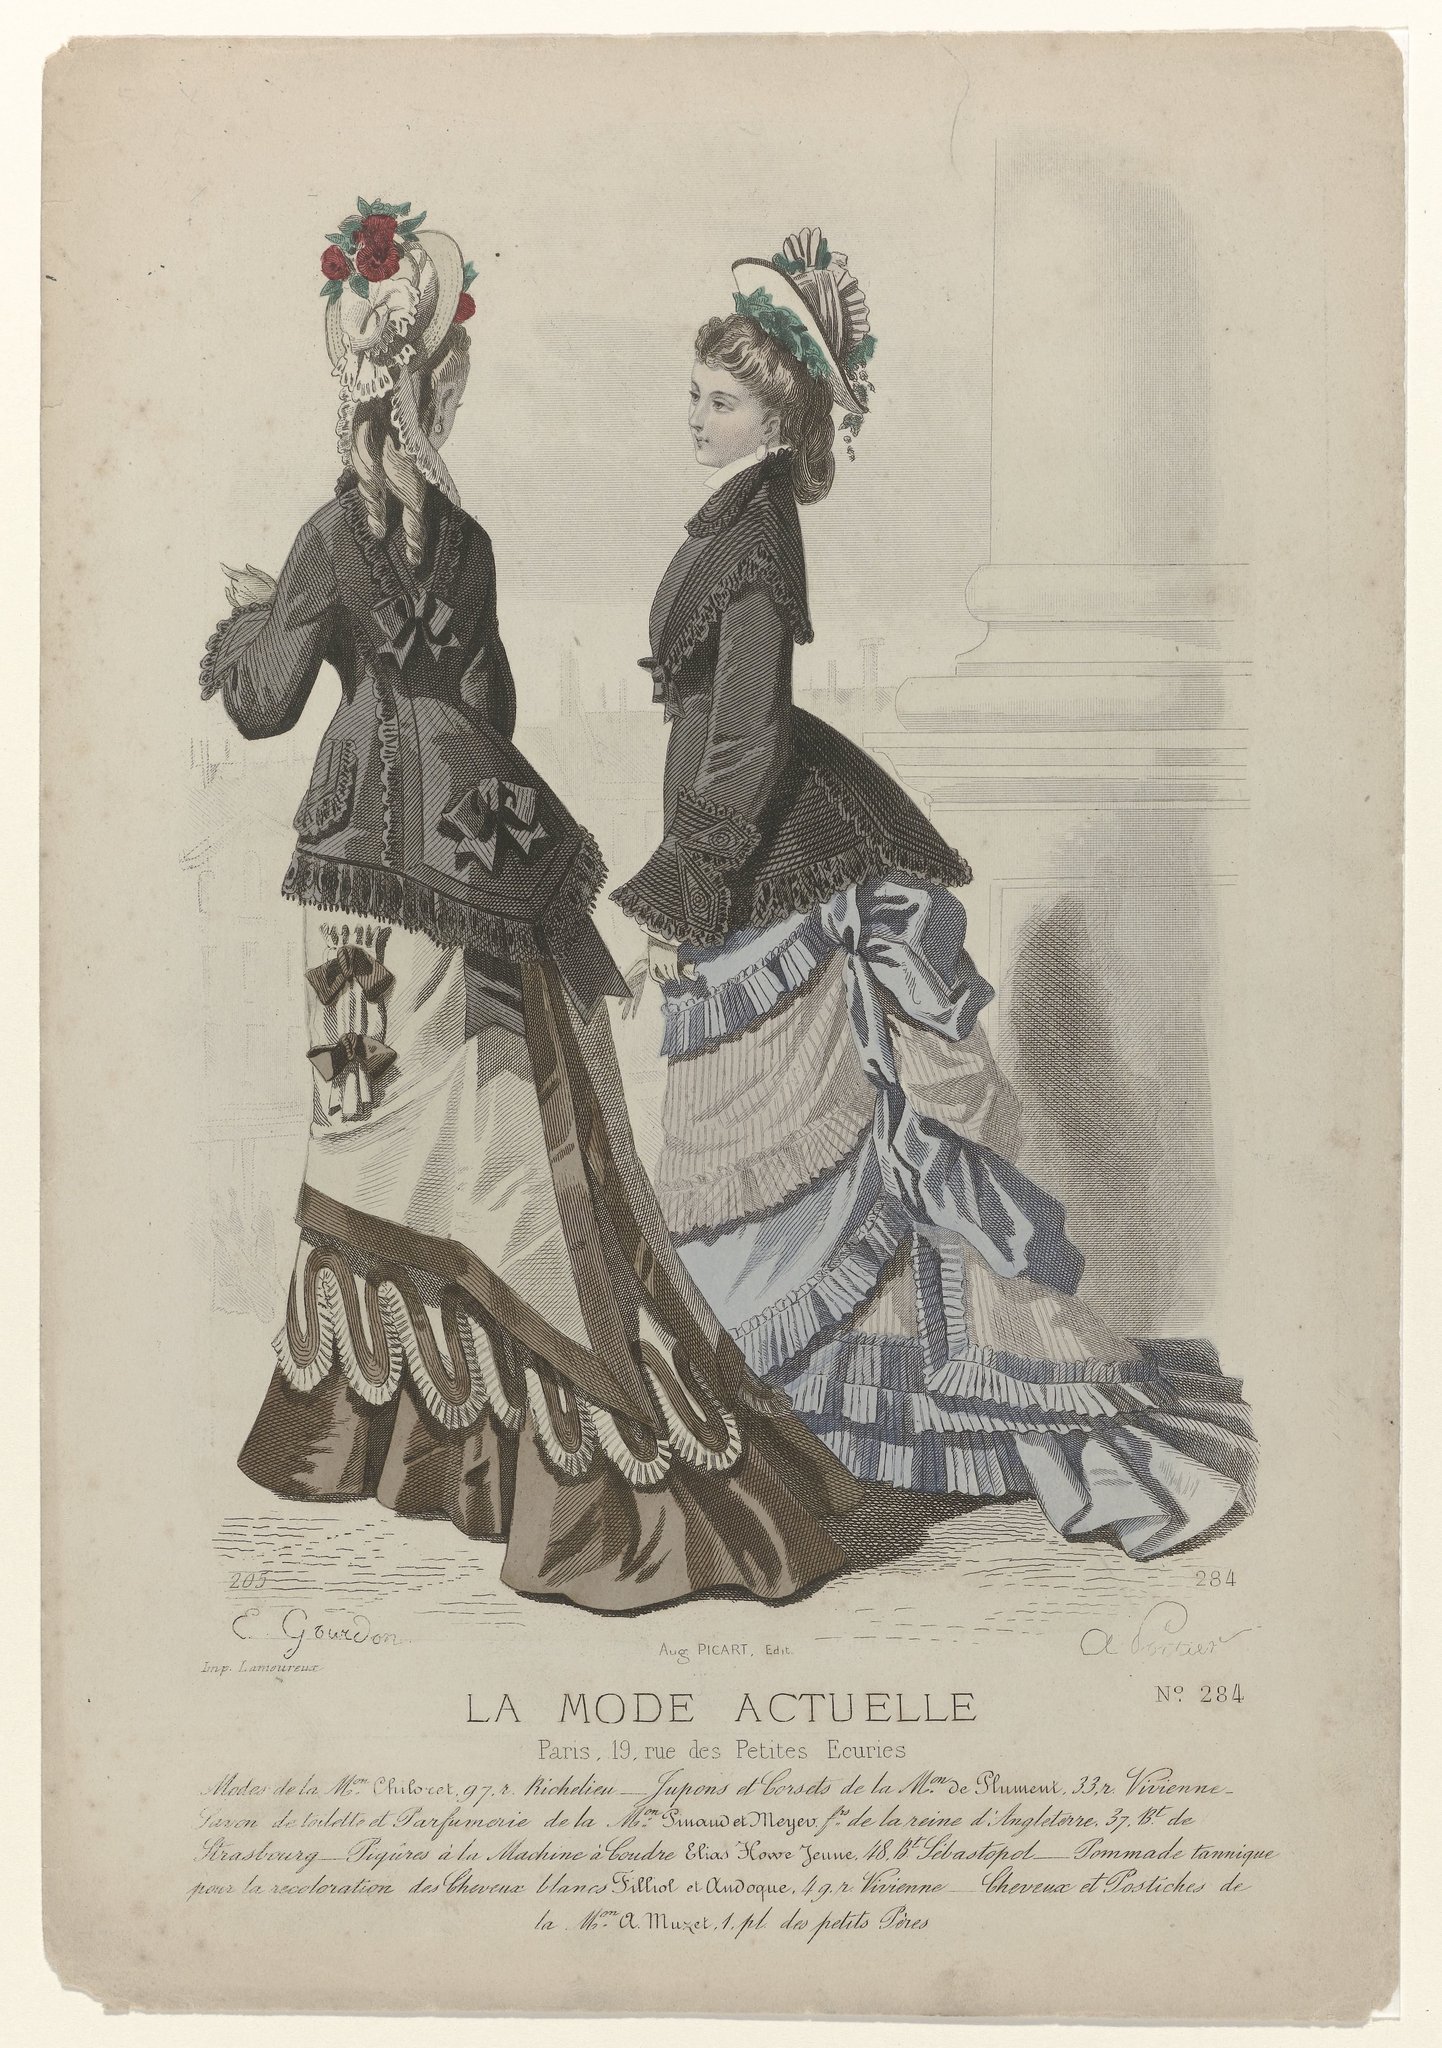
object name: fashion print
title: La Mode actuelle, ca. 1875, No 284 : Modes de la M.on Chiloret (...)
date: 1875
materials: paper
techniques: engraving, hand coloring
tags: coat (+ women's clothes), fashion plates, head-gear: hat (+ women's clothes), skirt (+ women's clothes), gloves, mittens, etc. (+ women's clothes)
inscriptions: caption: ‘Modes de la M.on Chiloret, 97.r. Richelieu _ Jupons et Corsets de la M.on de Plumet, 33, r. Vivienne _ Savon de toilette et Parfumerie de la M.on Pinaud et Meyer, f.rs de la reine d'Angleterre, 37, B.t de Strasbourg _ Piqûres à la Machine à Coudre Elias Howe Jeune. 48, B.t Sébastopol _ Pommade tannique pour la recoloration des Cheveux blancs Filliol et Andoque, 4 g. r Vivienne _ Cheveux et Postîches de la M.on A. Muzet, 1. pl. des petits Pères’, title: ‘La Mode actuelle’, address: ‘Paris, 19, rue des Petites Ecuries’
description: Twee vrouwen, van wie één op de rug gezien. Onder de voorstelling enkele regels reclametekst voor verschillende producten.